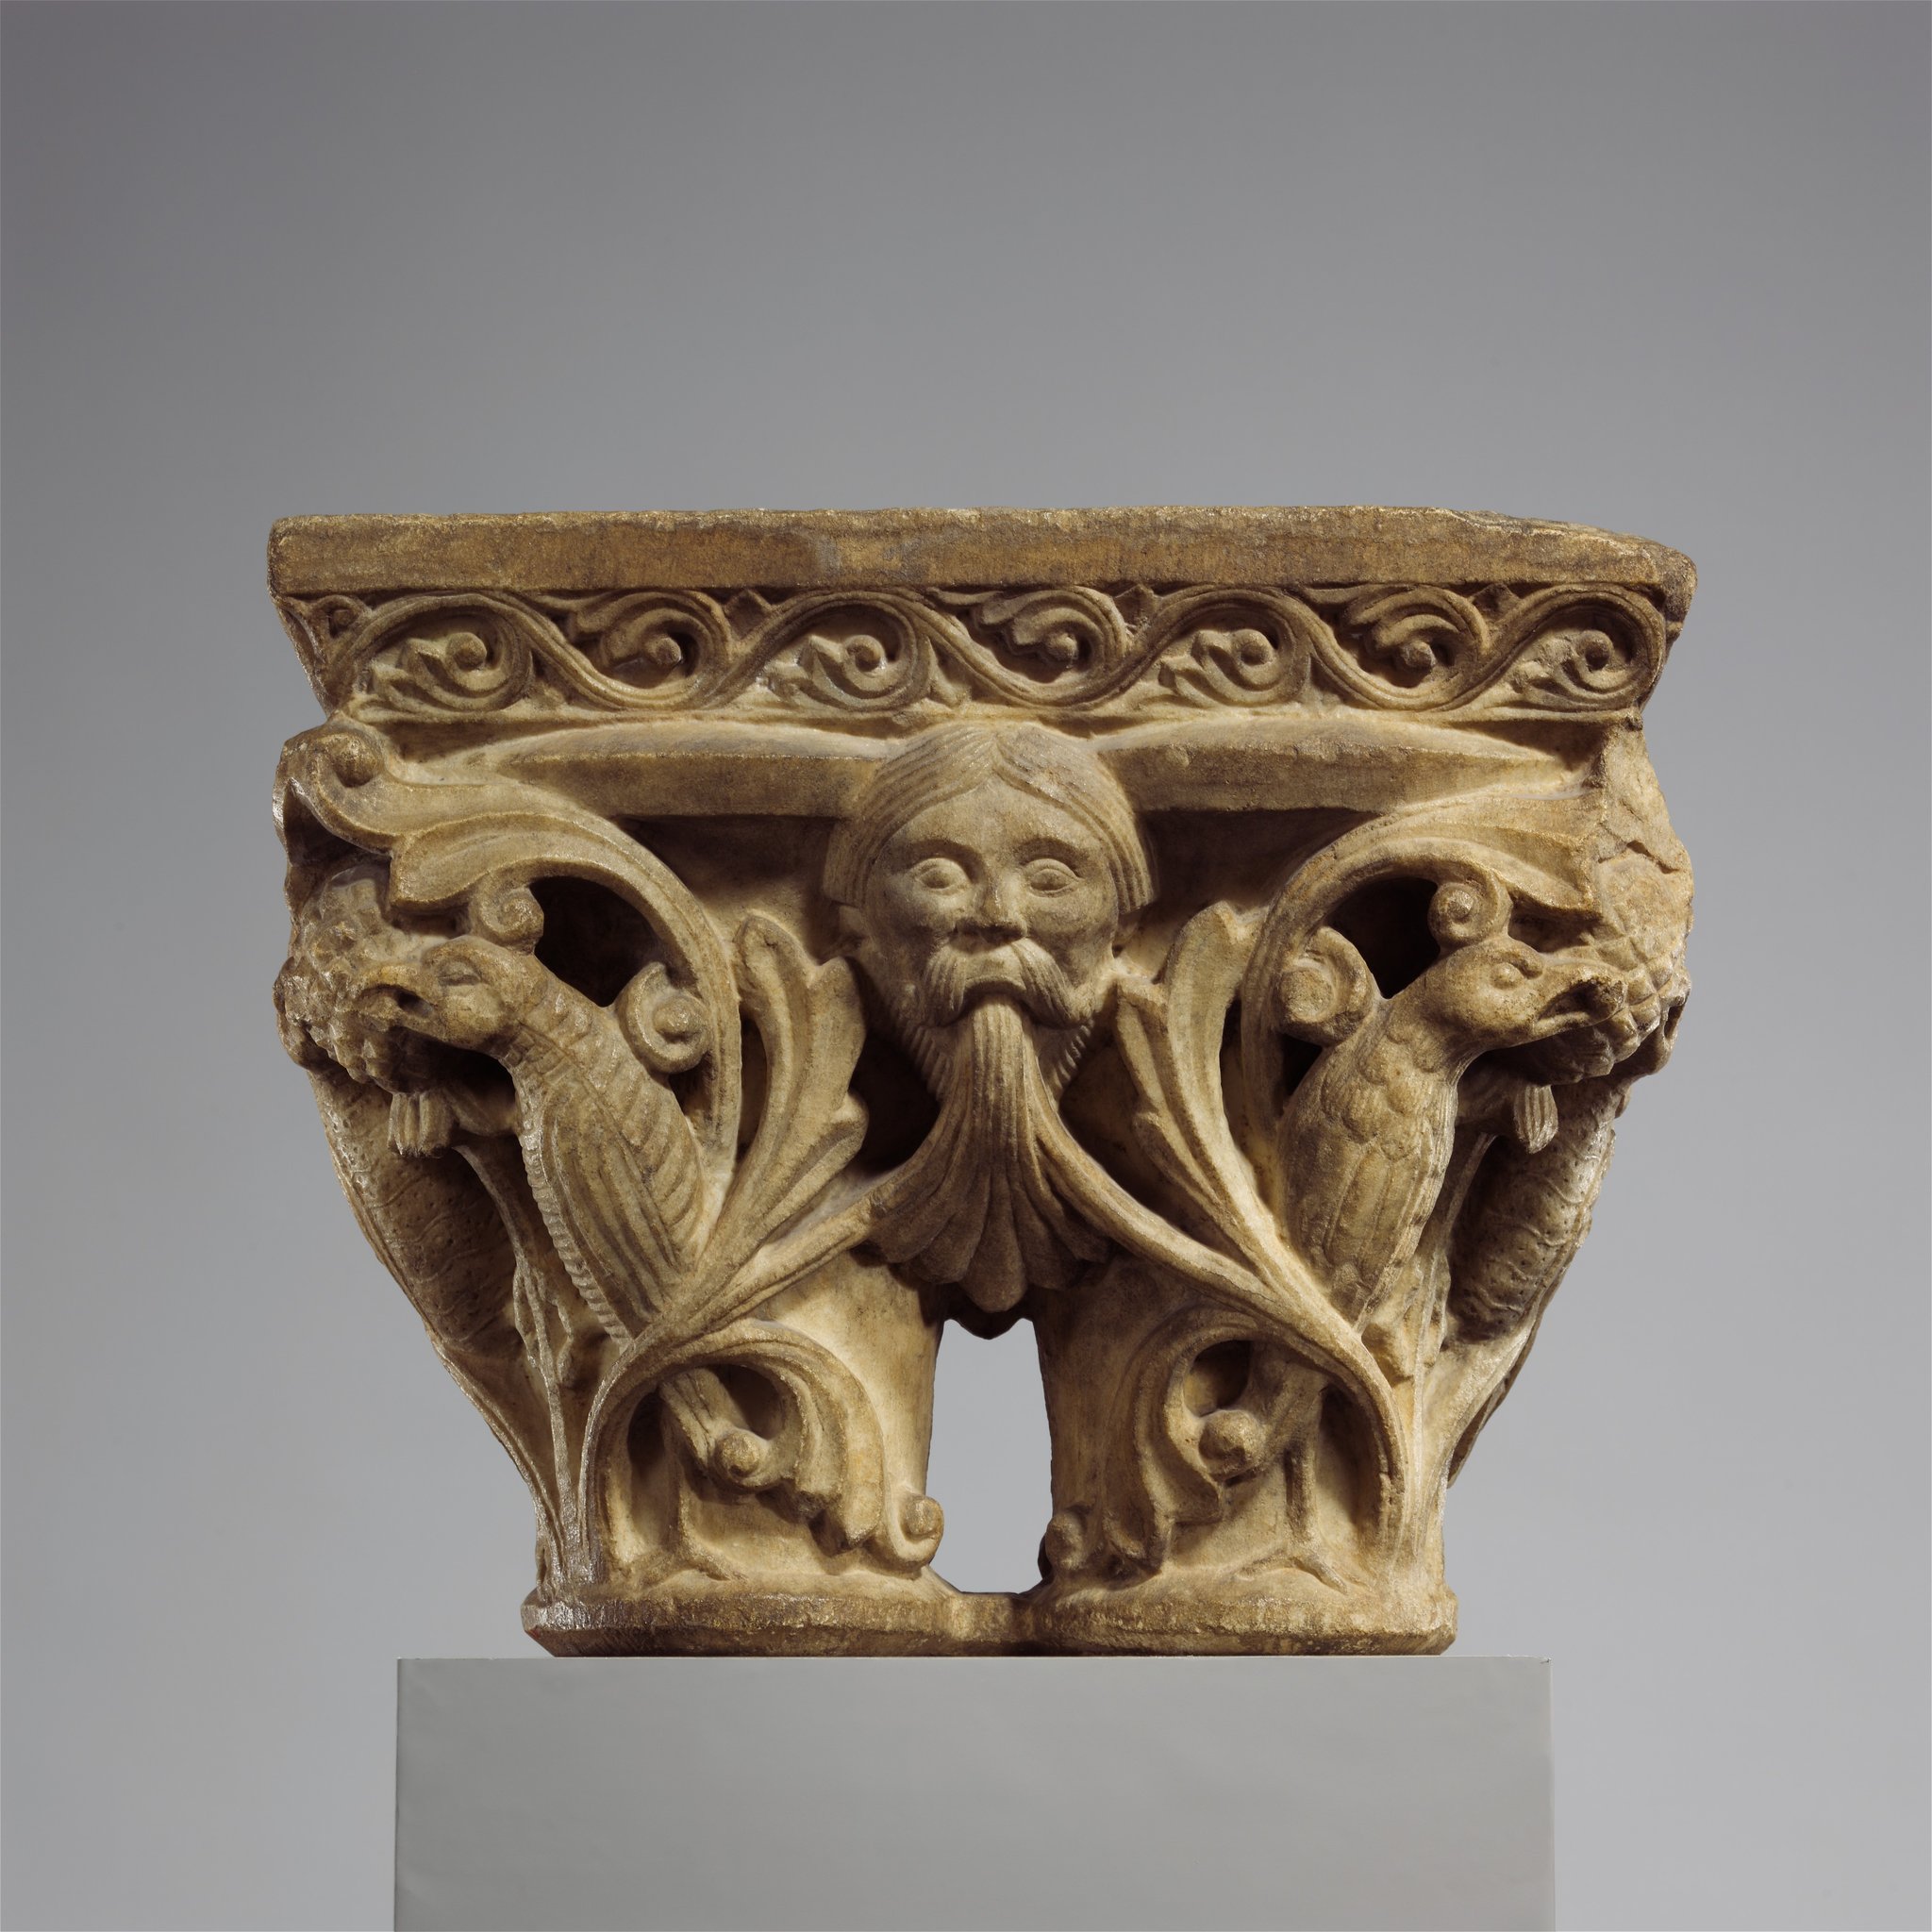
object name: capital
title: Double Capital with Masks and Birds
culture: french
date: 1140-1160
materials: marble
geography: france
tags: birds,masks